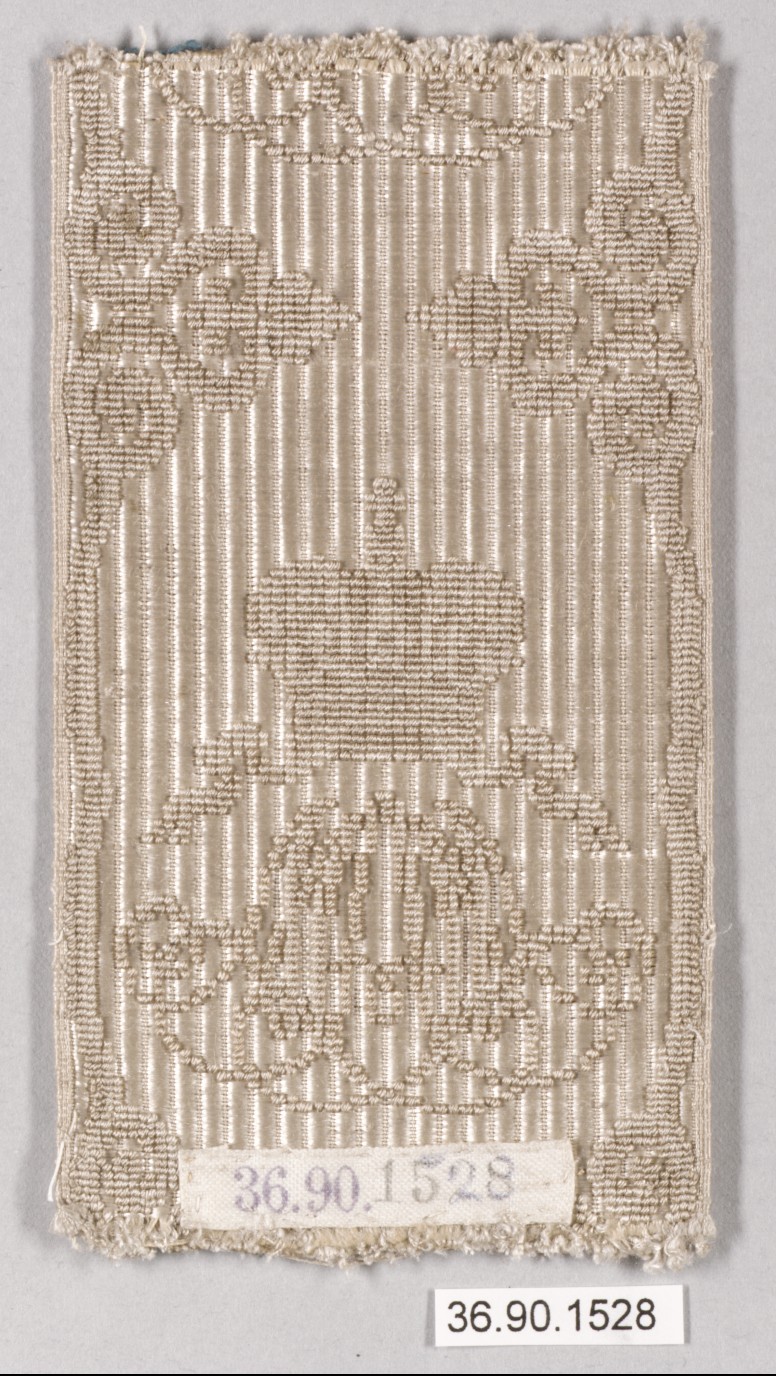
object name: galloon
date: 1701-1900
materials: silk